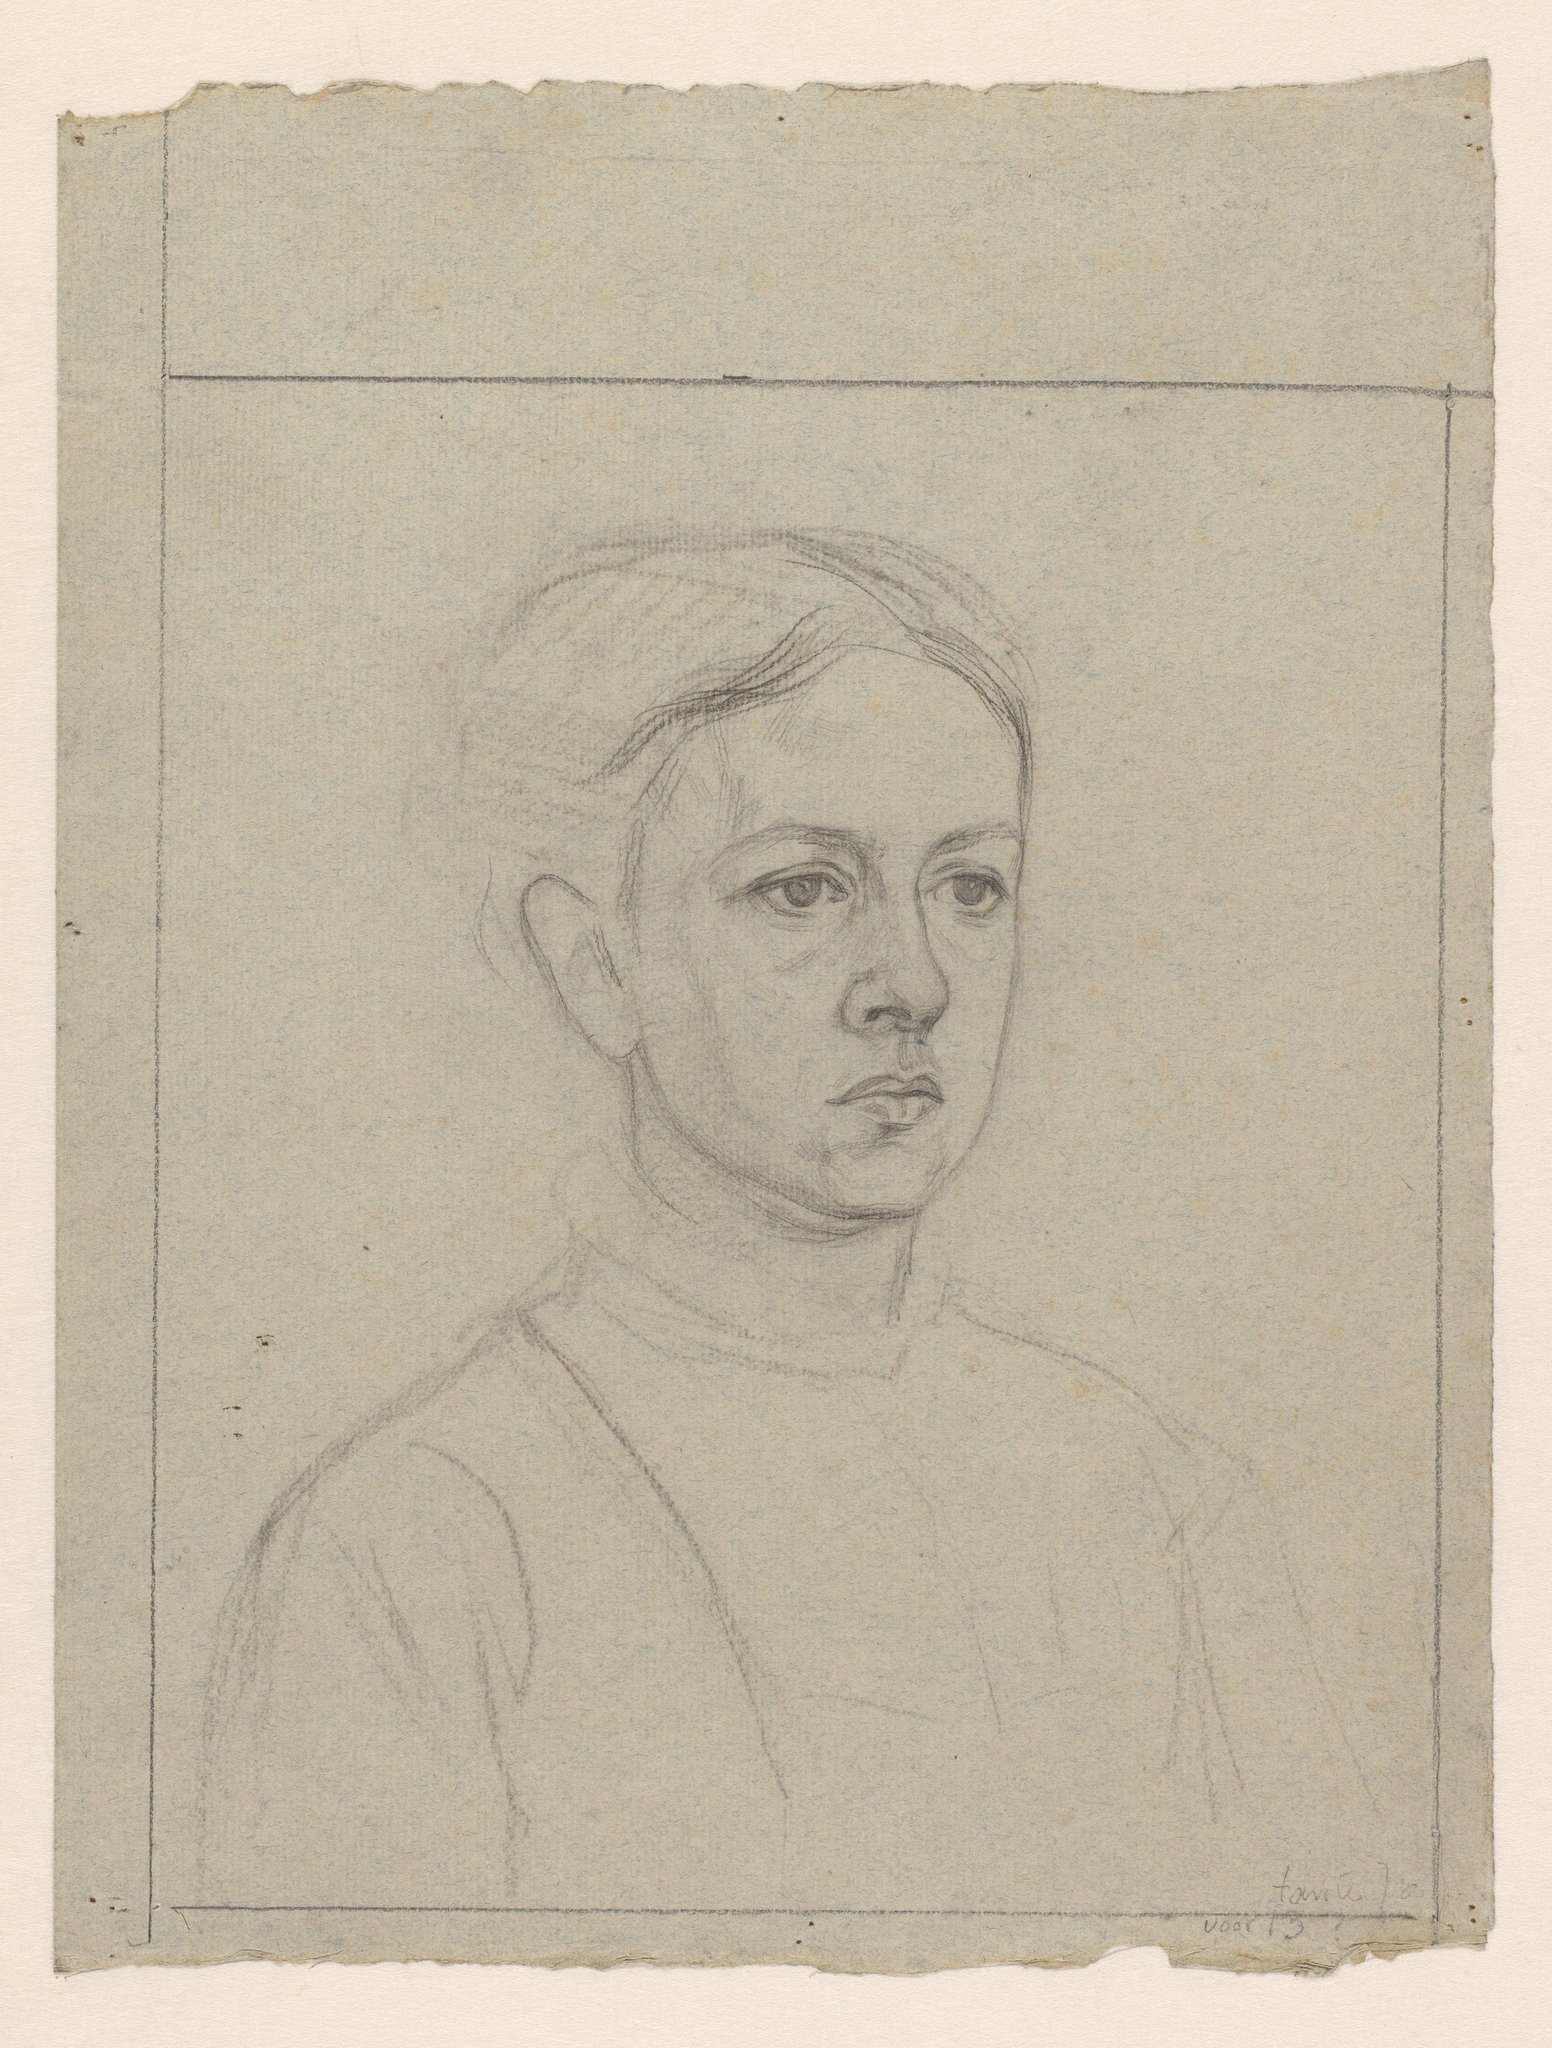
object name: drawing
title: Portret van Johanna Veth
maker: jan veth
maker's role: designer, draughtsman, painter, print maker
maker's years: 1864-1925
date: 1874-1925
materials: chalk, paper, pencil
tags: historical persons